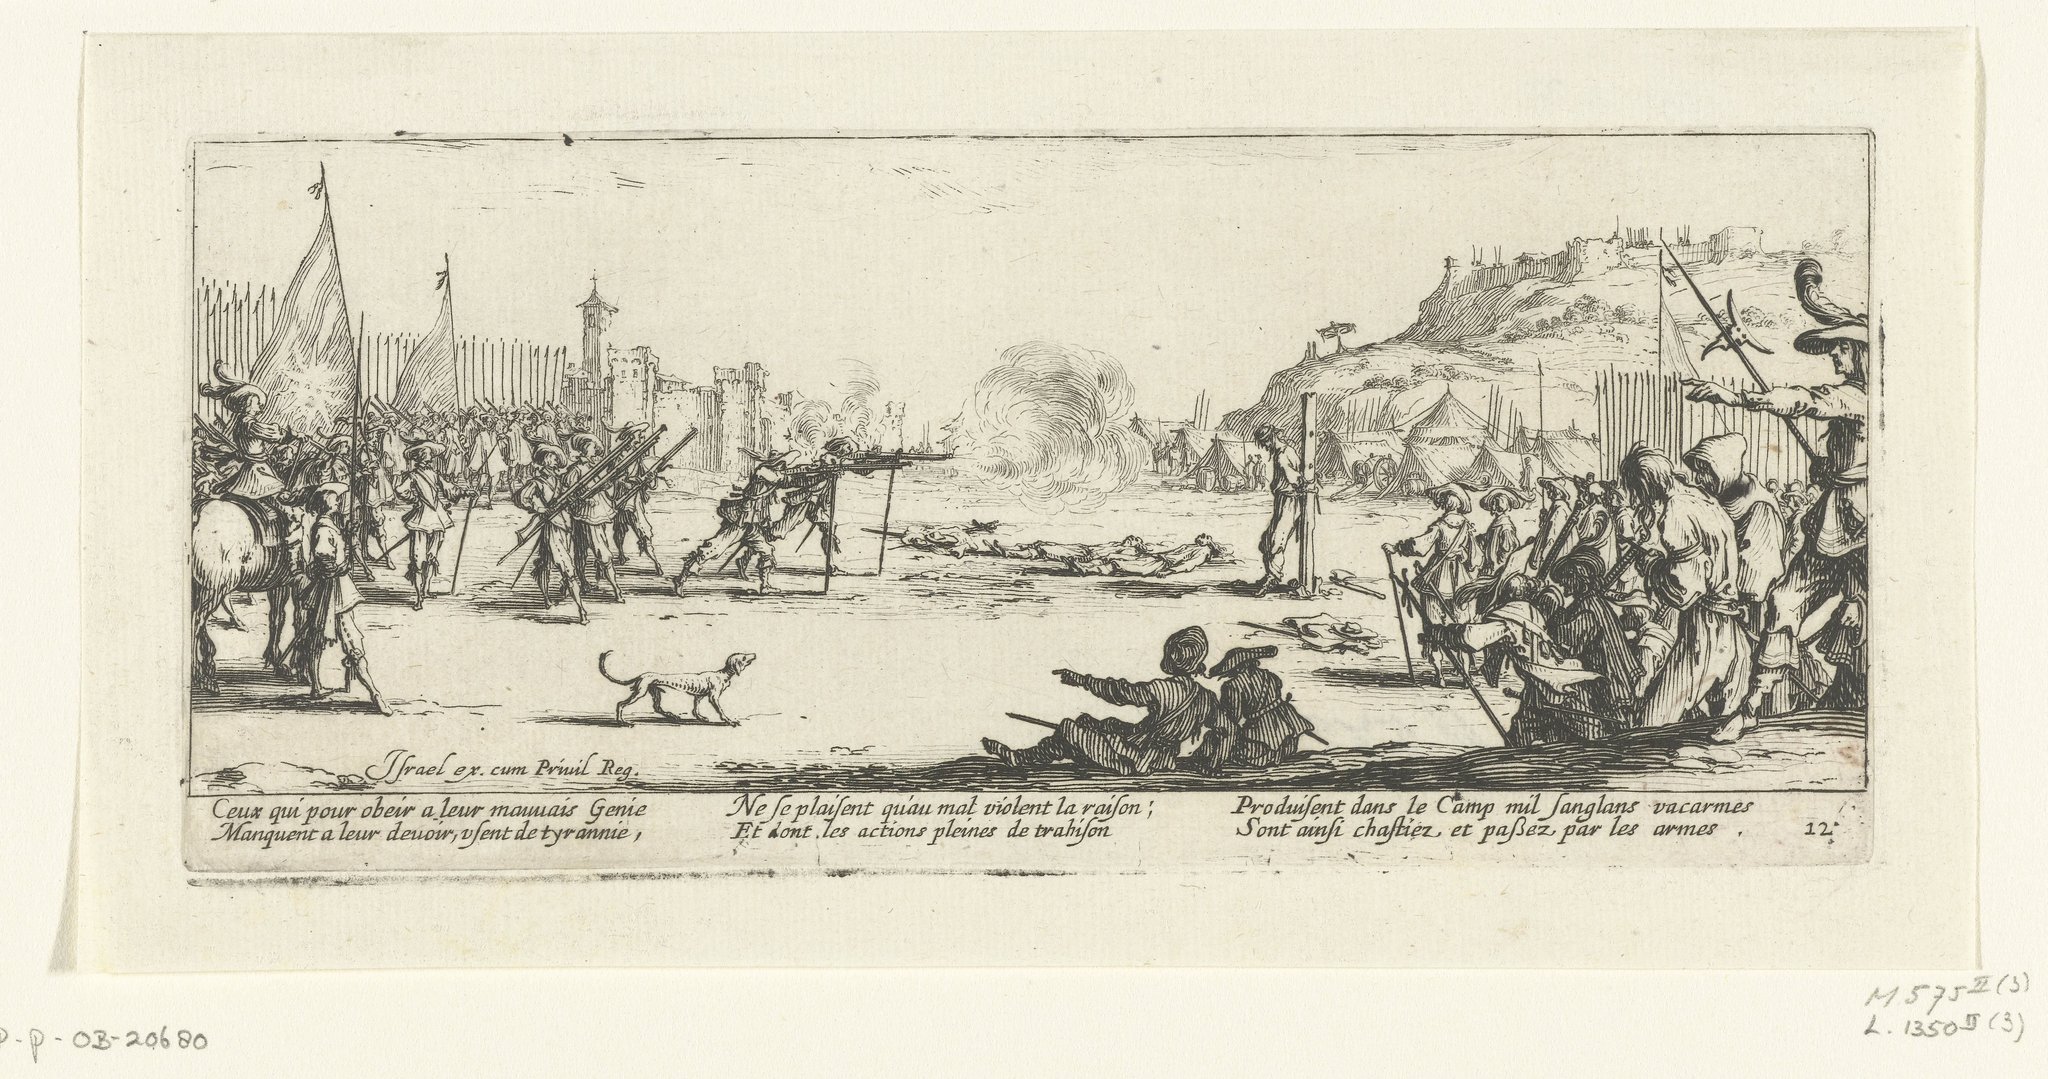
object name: print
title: Les miseres et les malheurs de la guerre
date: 1633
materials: paper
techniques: etching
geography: paris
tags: (military) camp with tents, firearms: rifle, execution ~ military disciplinary punishment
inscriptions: collector's mark: Lugt 240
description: Op een open plek in een legerkamp vlakbij een burcht kijken vele soldaten toe hoe een man, aan een paal gebonden, wordt doodgeschoten door een vuurpeloton. Op de grond naast de paal liggen reeds twee lijken. Onder de voorstelling een zesregelig Frans vers. Deze prent is onderdeel van een serie van 17 (18 incl. titelprent) prenten met voorstellingen van diverse soorten ellende die oorlogvoering met zich meebrengt.